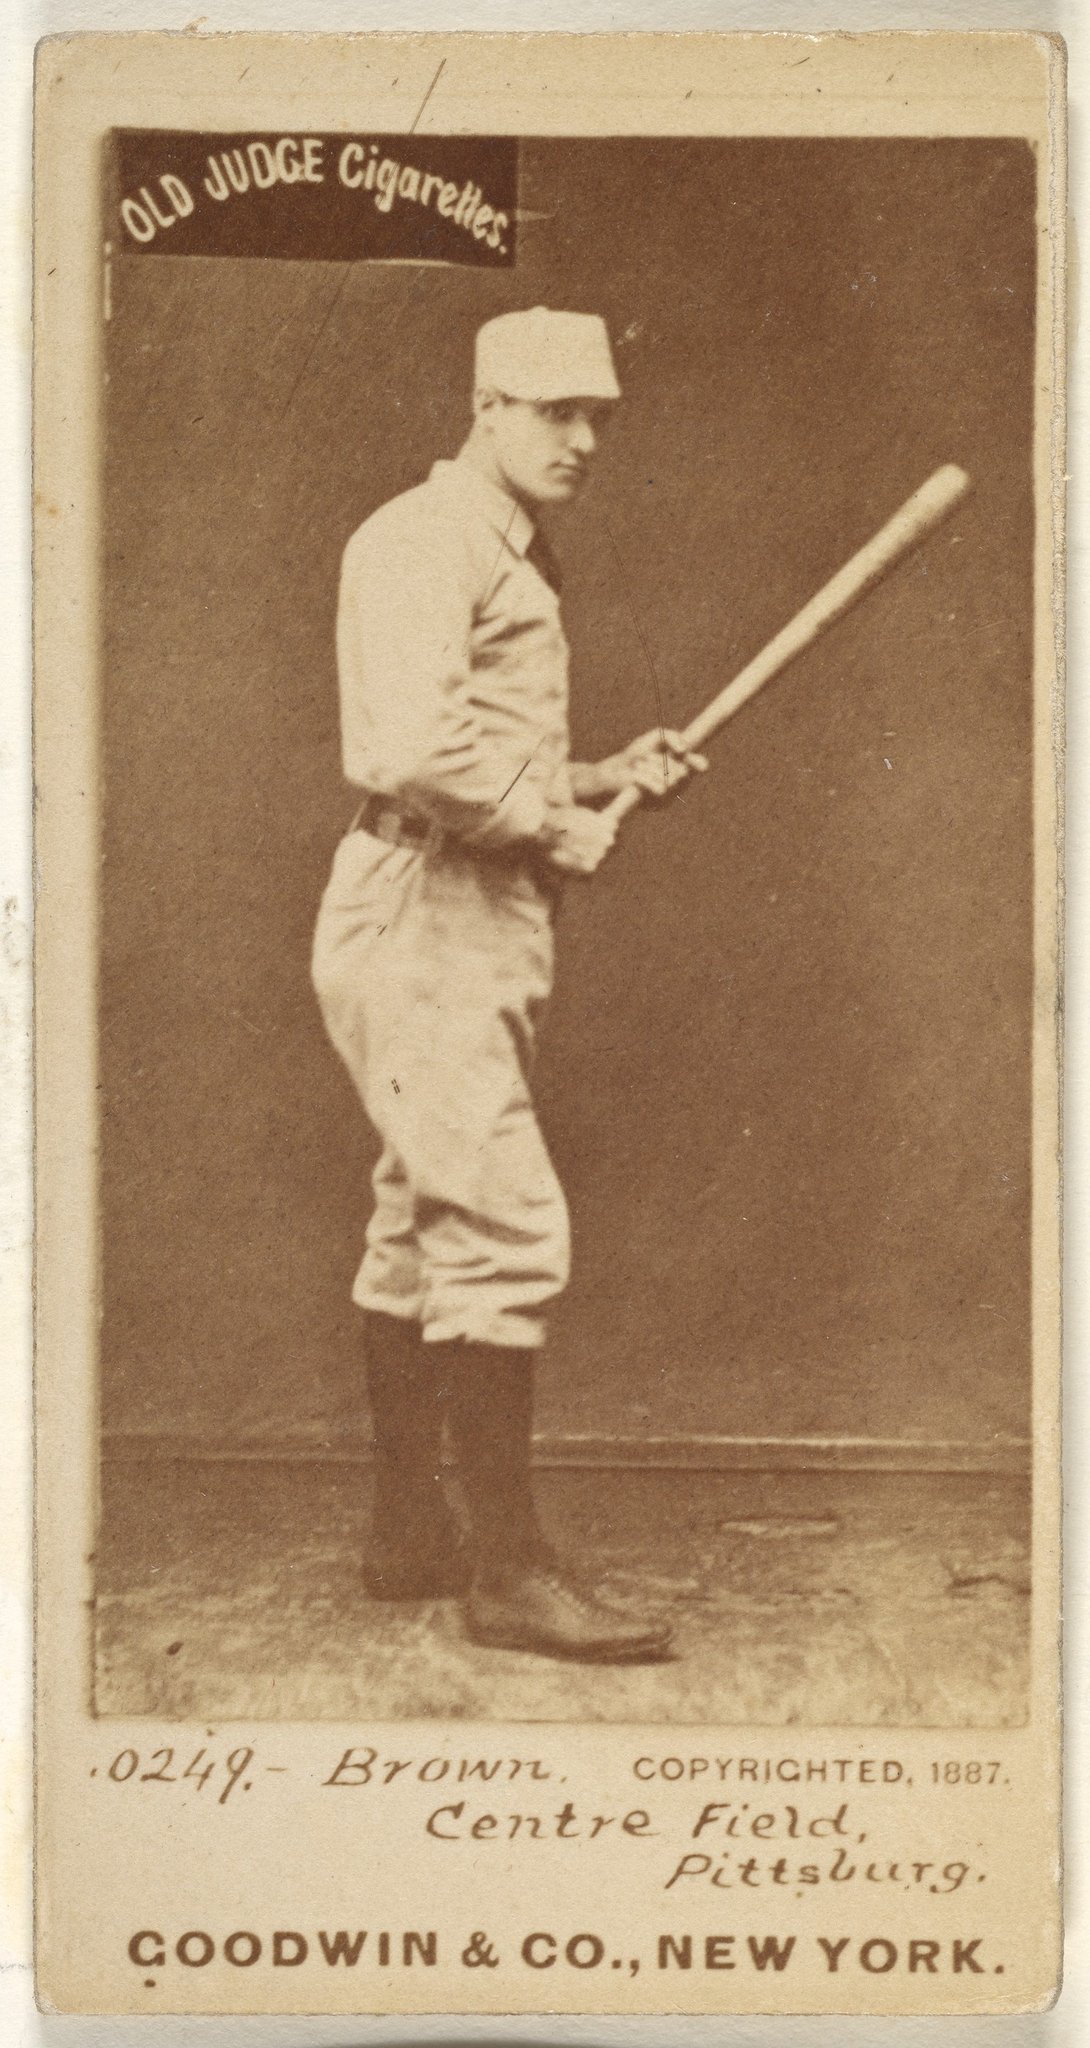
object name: baseball card, photograph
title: Thomas "Tom" Tarlton Brown, Center Field, Pittsburgh, from the Old Judge series (N172) for Old Judge Cigarettes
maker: goodwin & company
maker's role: publisher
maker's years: 1850-1950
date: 1887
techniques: albumen silver print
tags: men,portraits,baseball,athletes